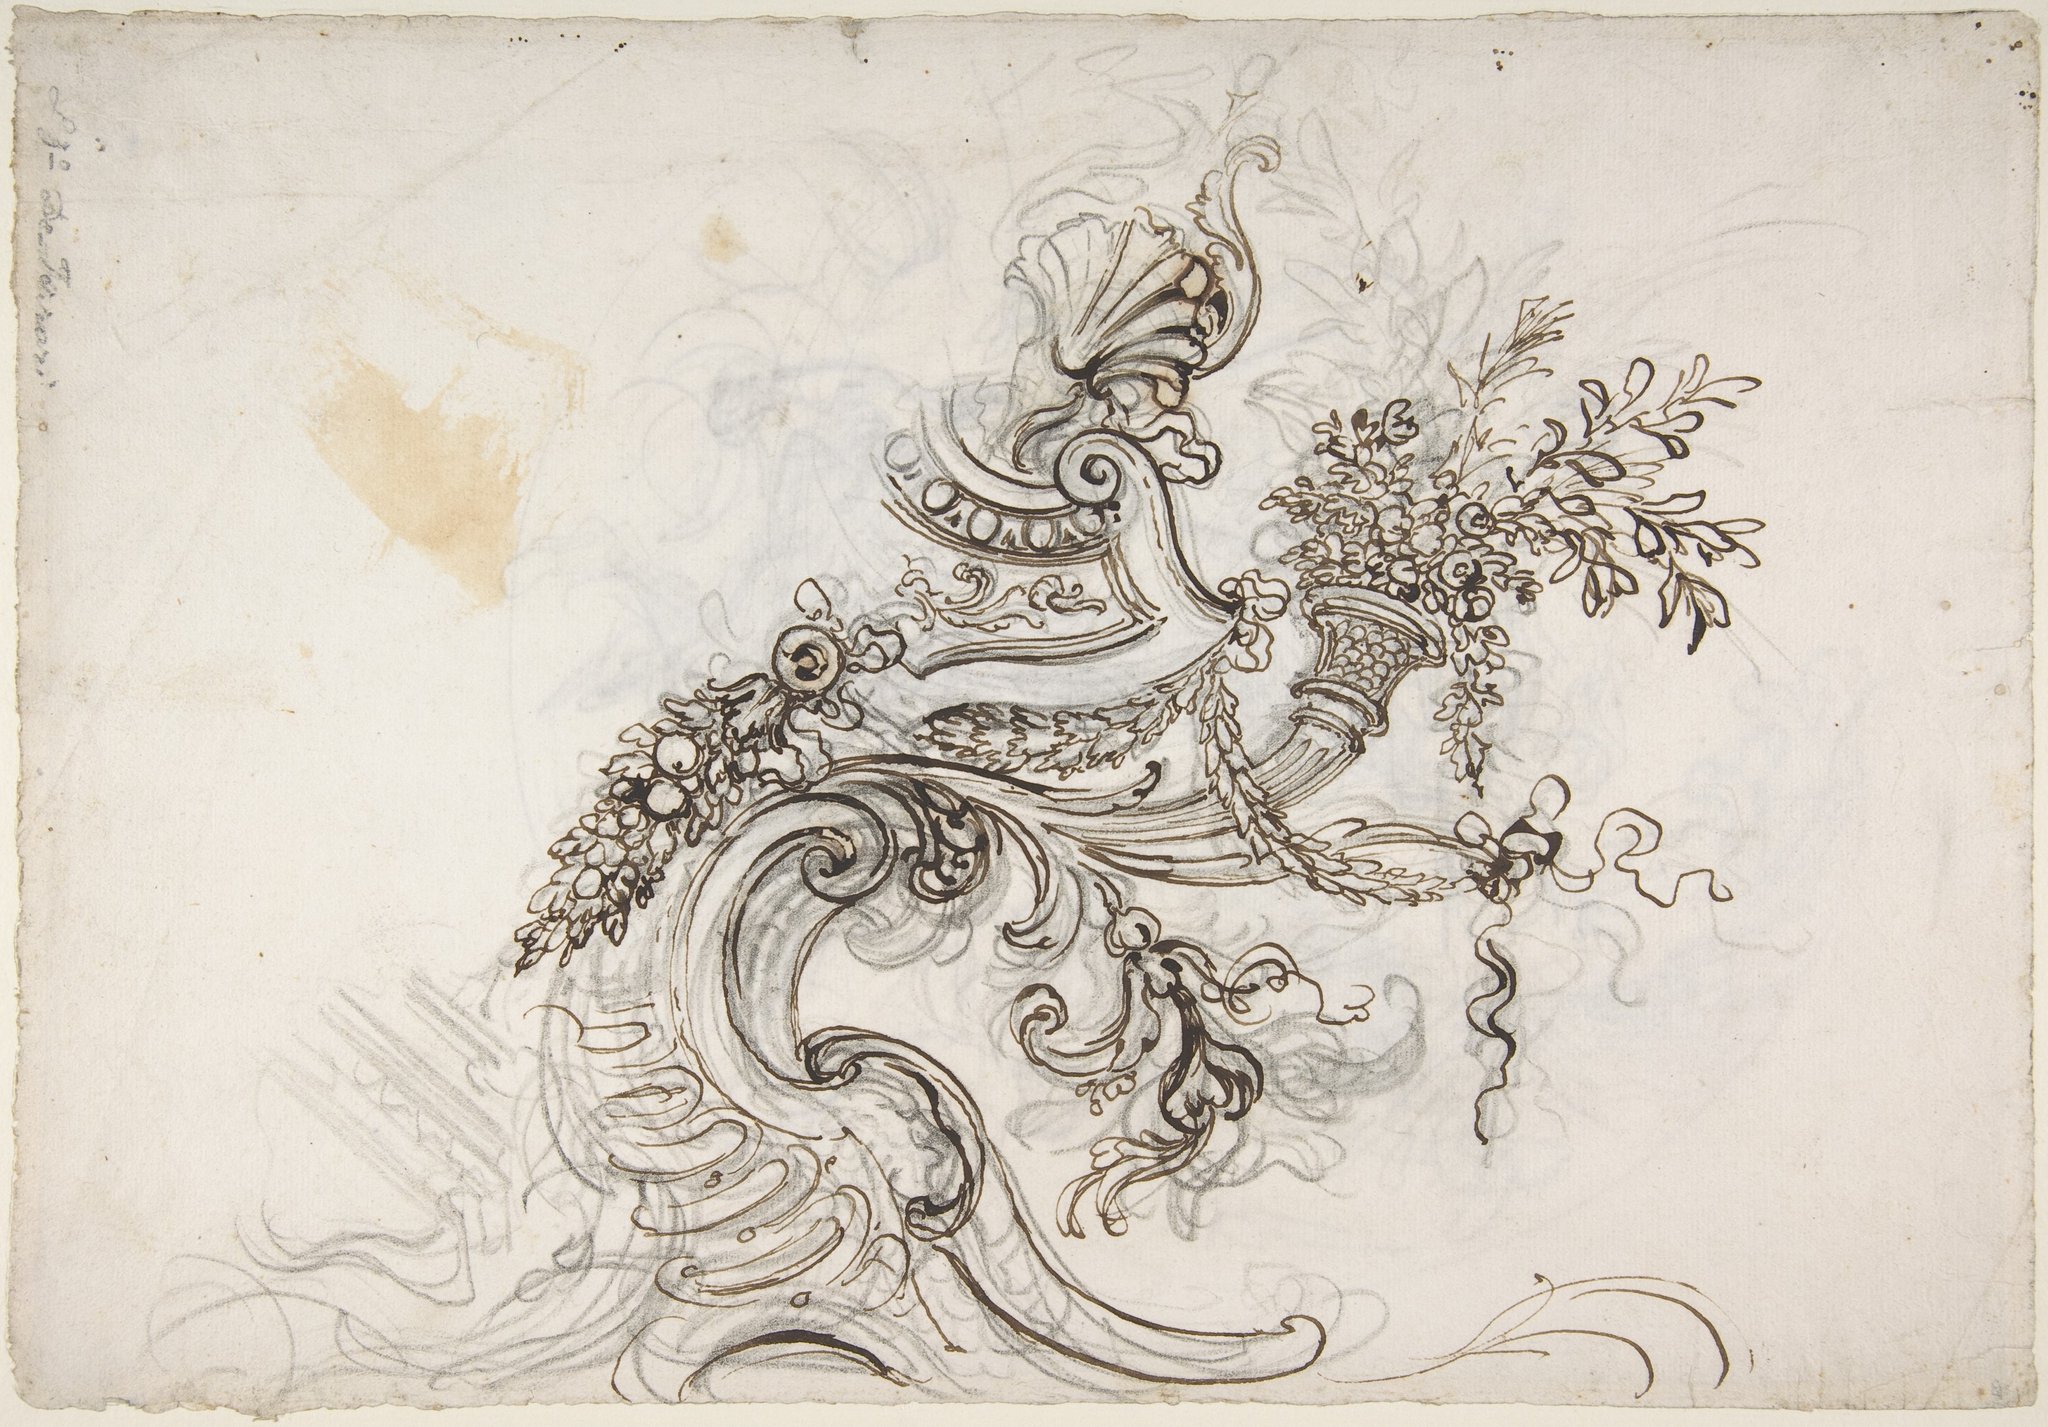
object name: drawing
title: Design for a Ceiling Decoration (recto); Daphne Pursued by Apollo (verso)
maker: lorenzo de' ferrari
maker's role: artist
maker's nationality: italian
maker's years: 1680-1744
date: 1680-1744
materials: chalk, ink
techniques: pen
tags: ornament